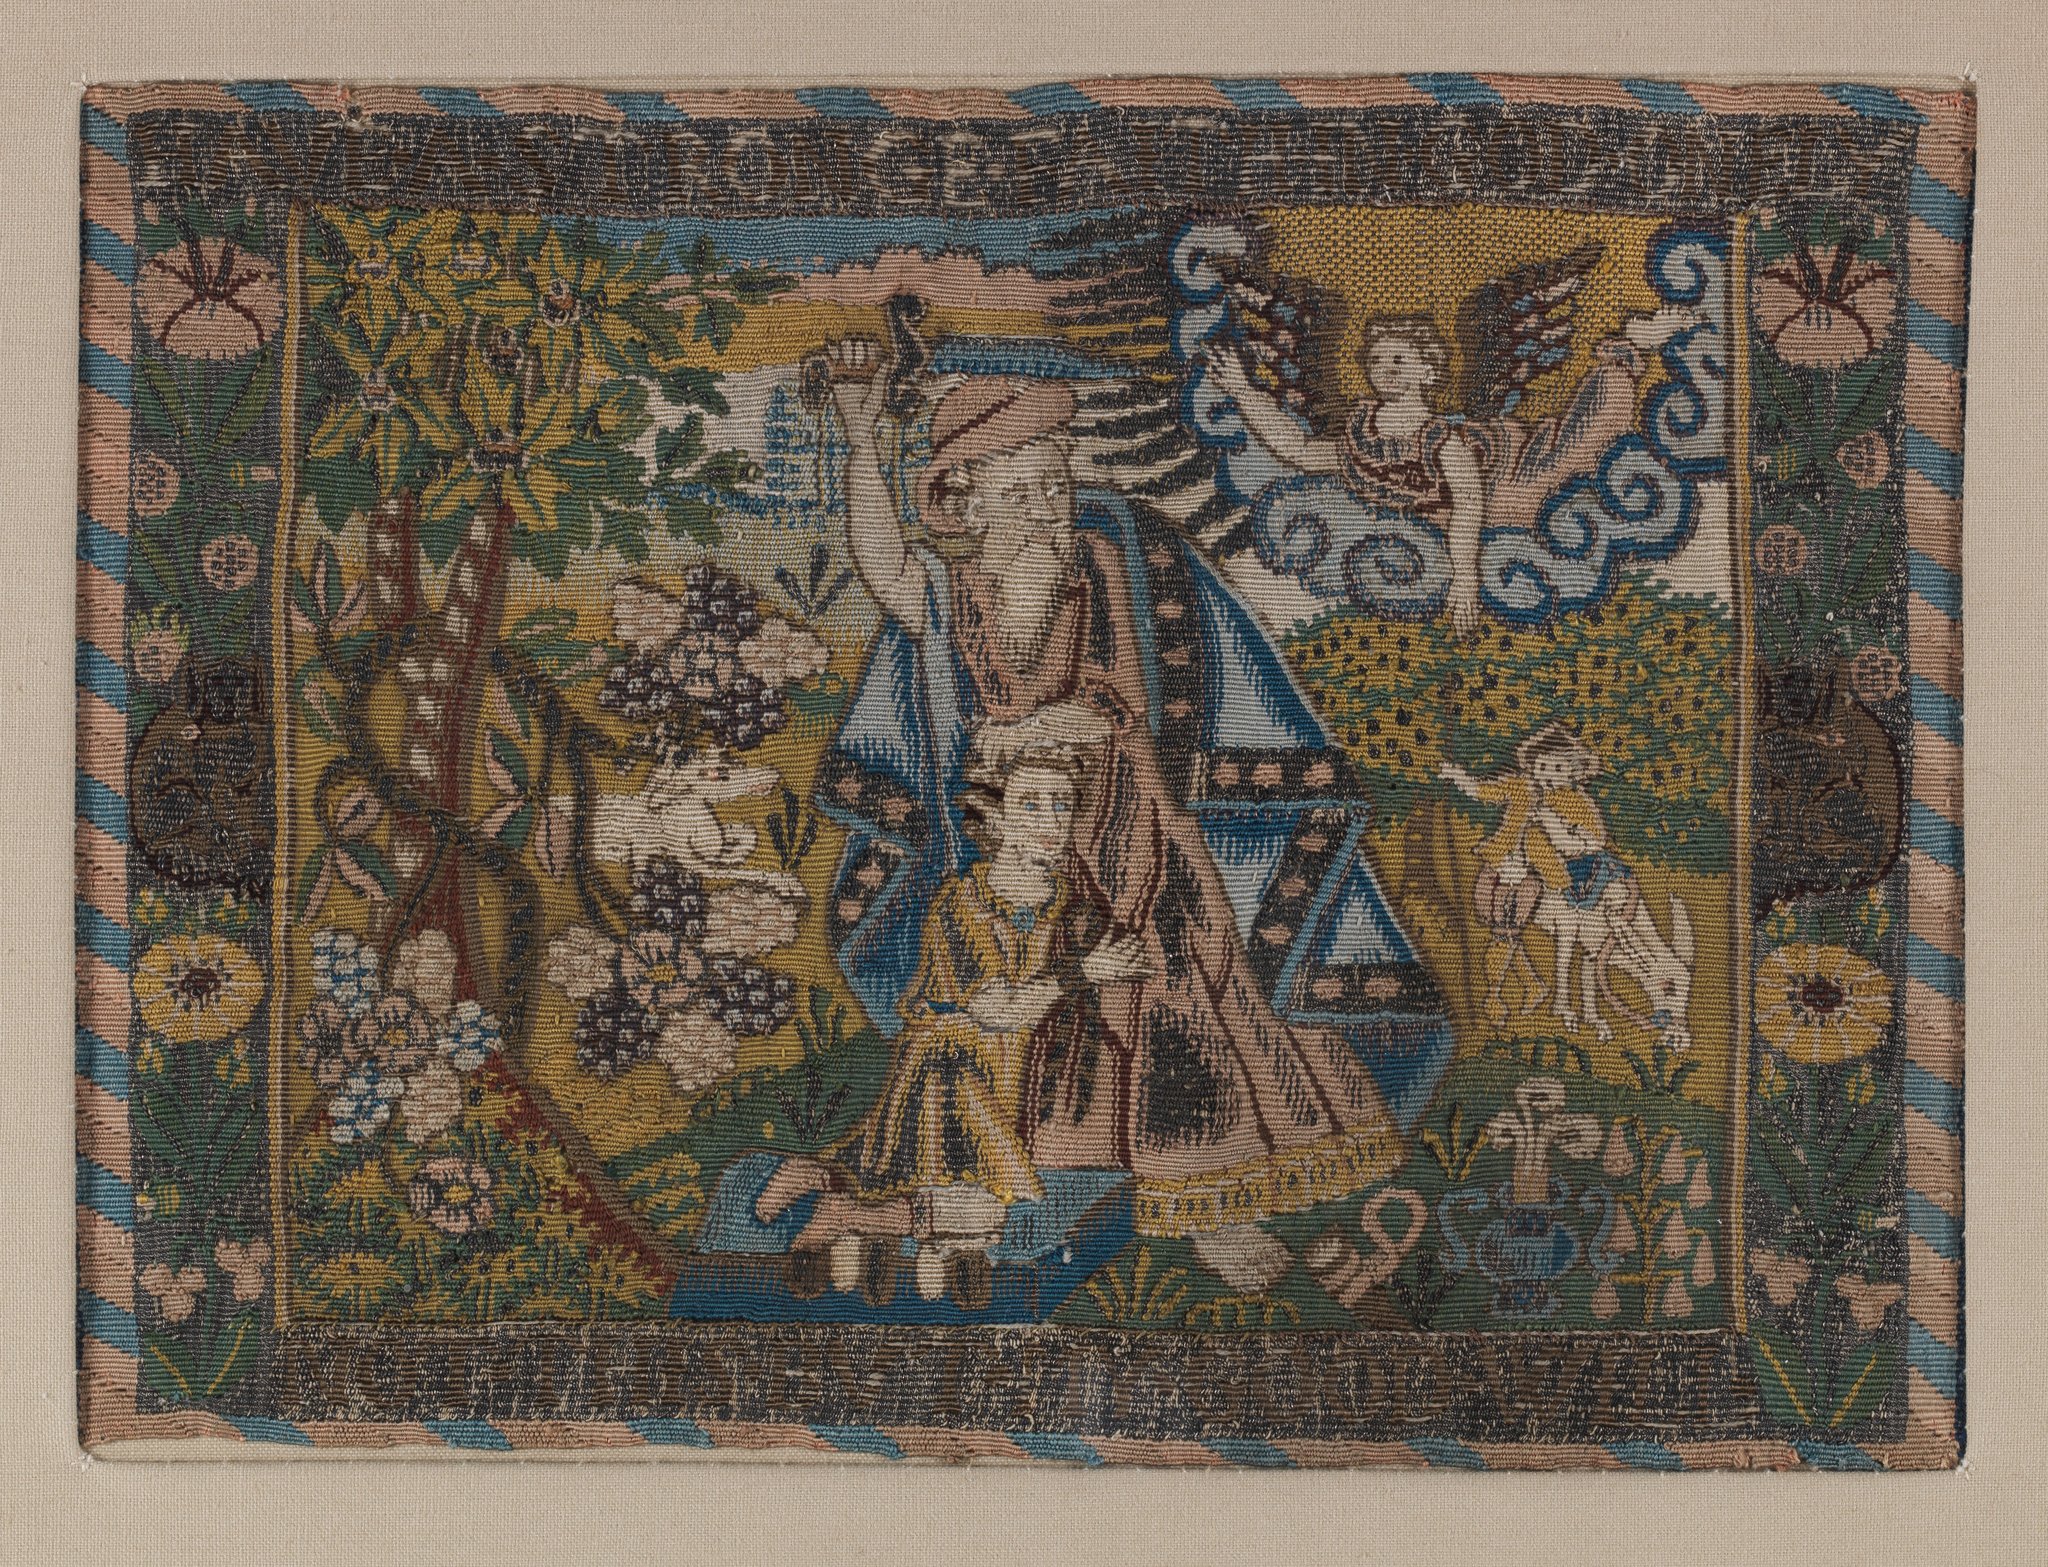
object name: picture, tapestry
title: The Sacrifice of Isaac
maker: william sheldon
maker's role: maker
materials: silk, thread, wool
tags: animals,men,flowers,trees